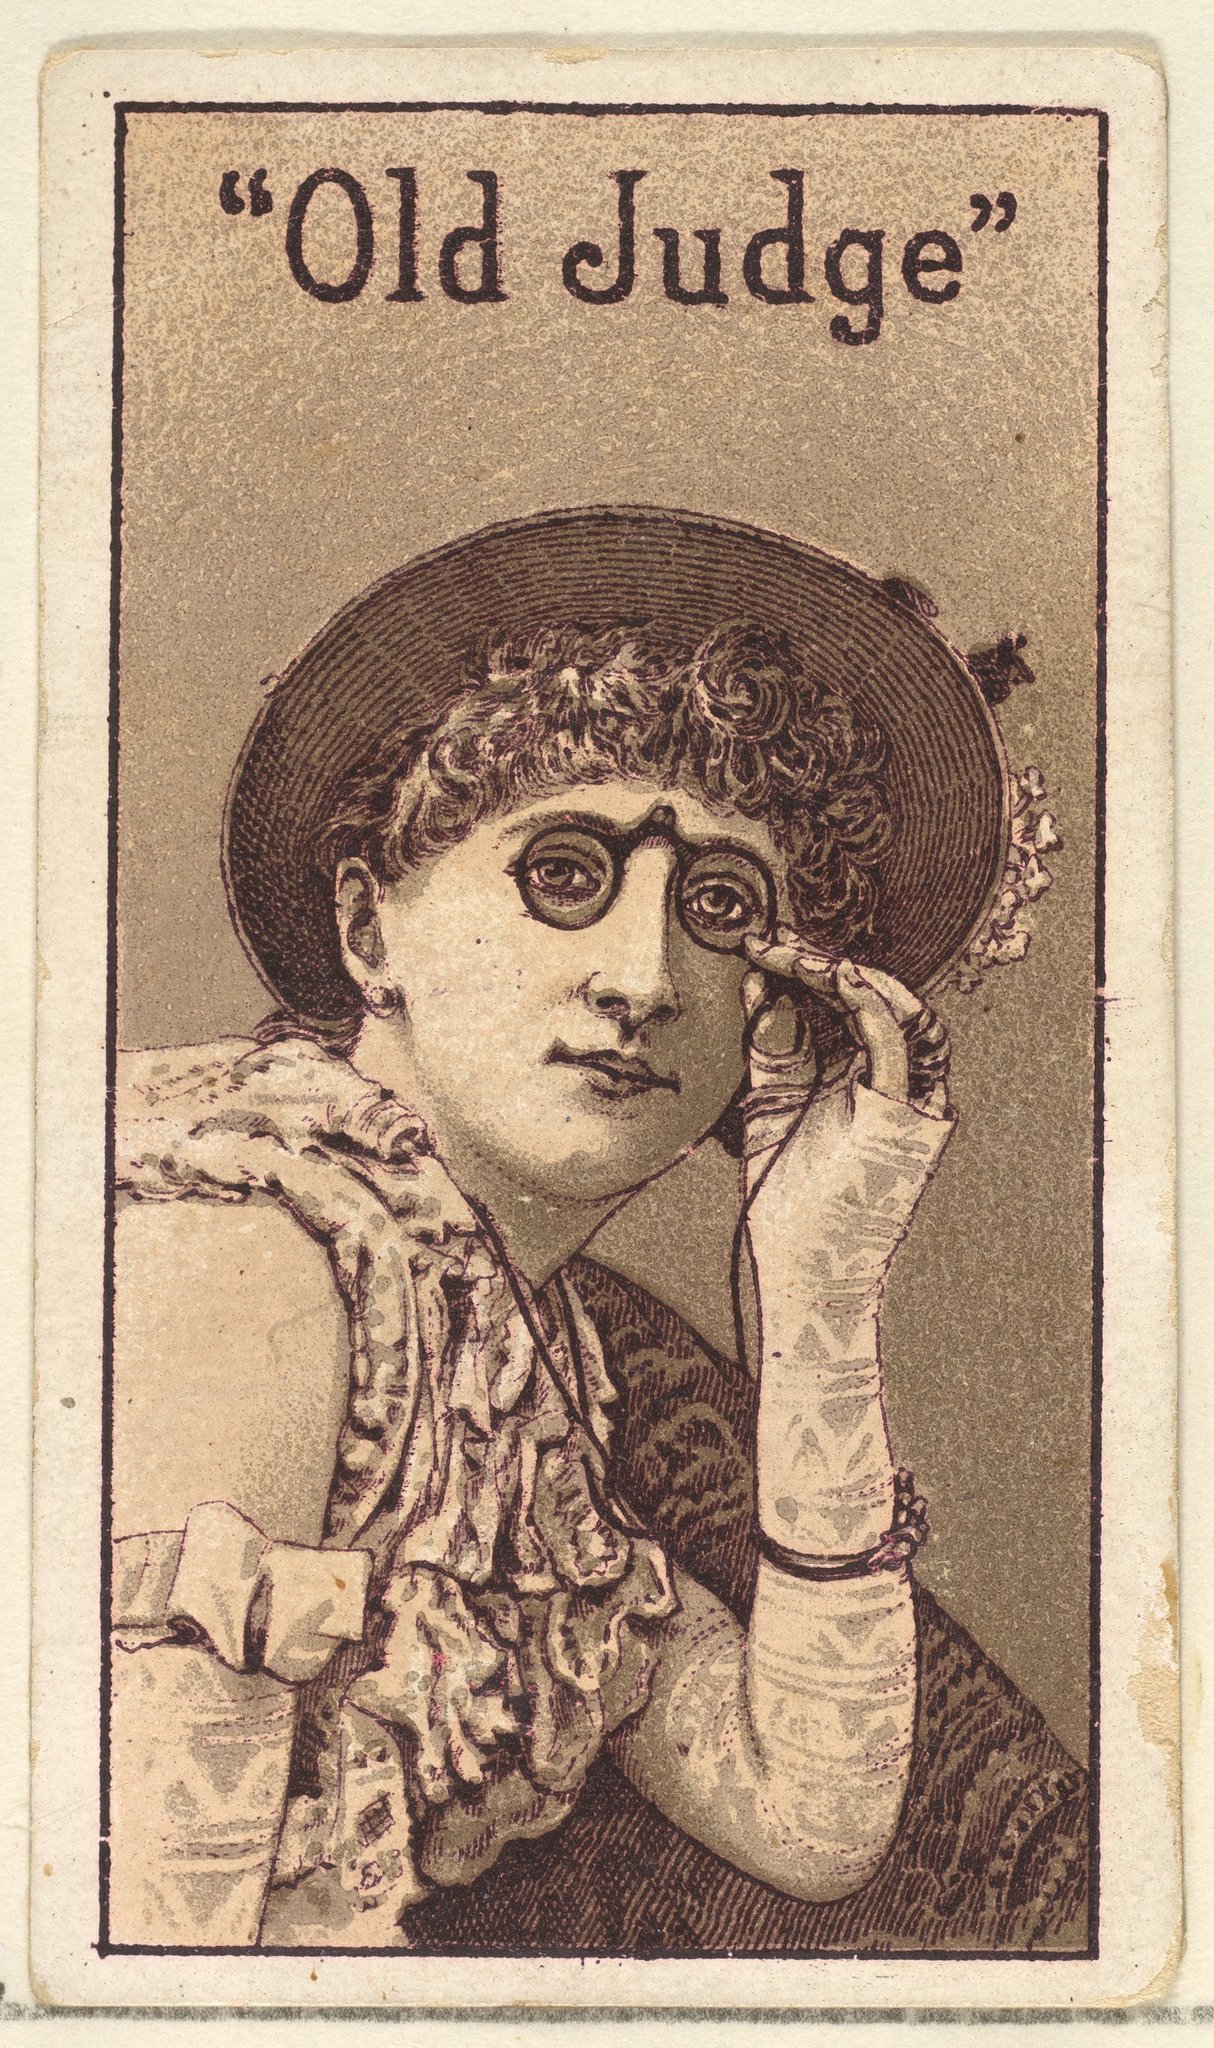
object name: print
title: Actress from the Old Judge series (N167) for Old Judge Cigarettes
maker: goodwin & company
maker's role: publisher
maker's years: 1850-1950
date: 1886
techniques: lithography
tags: portraits,women